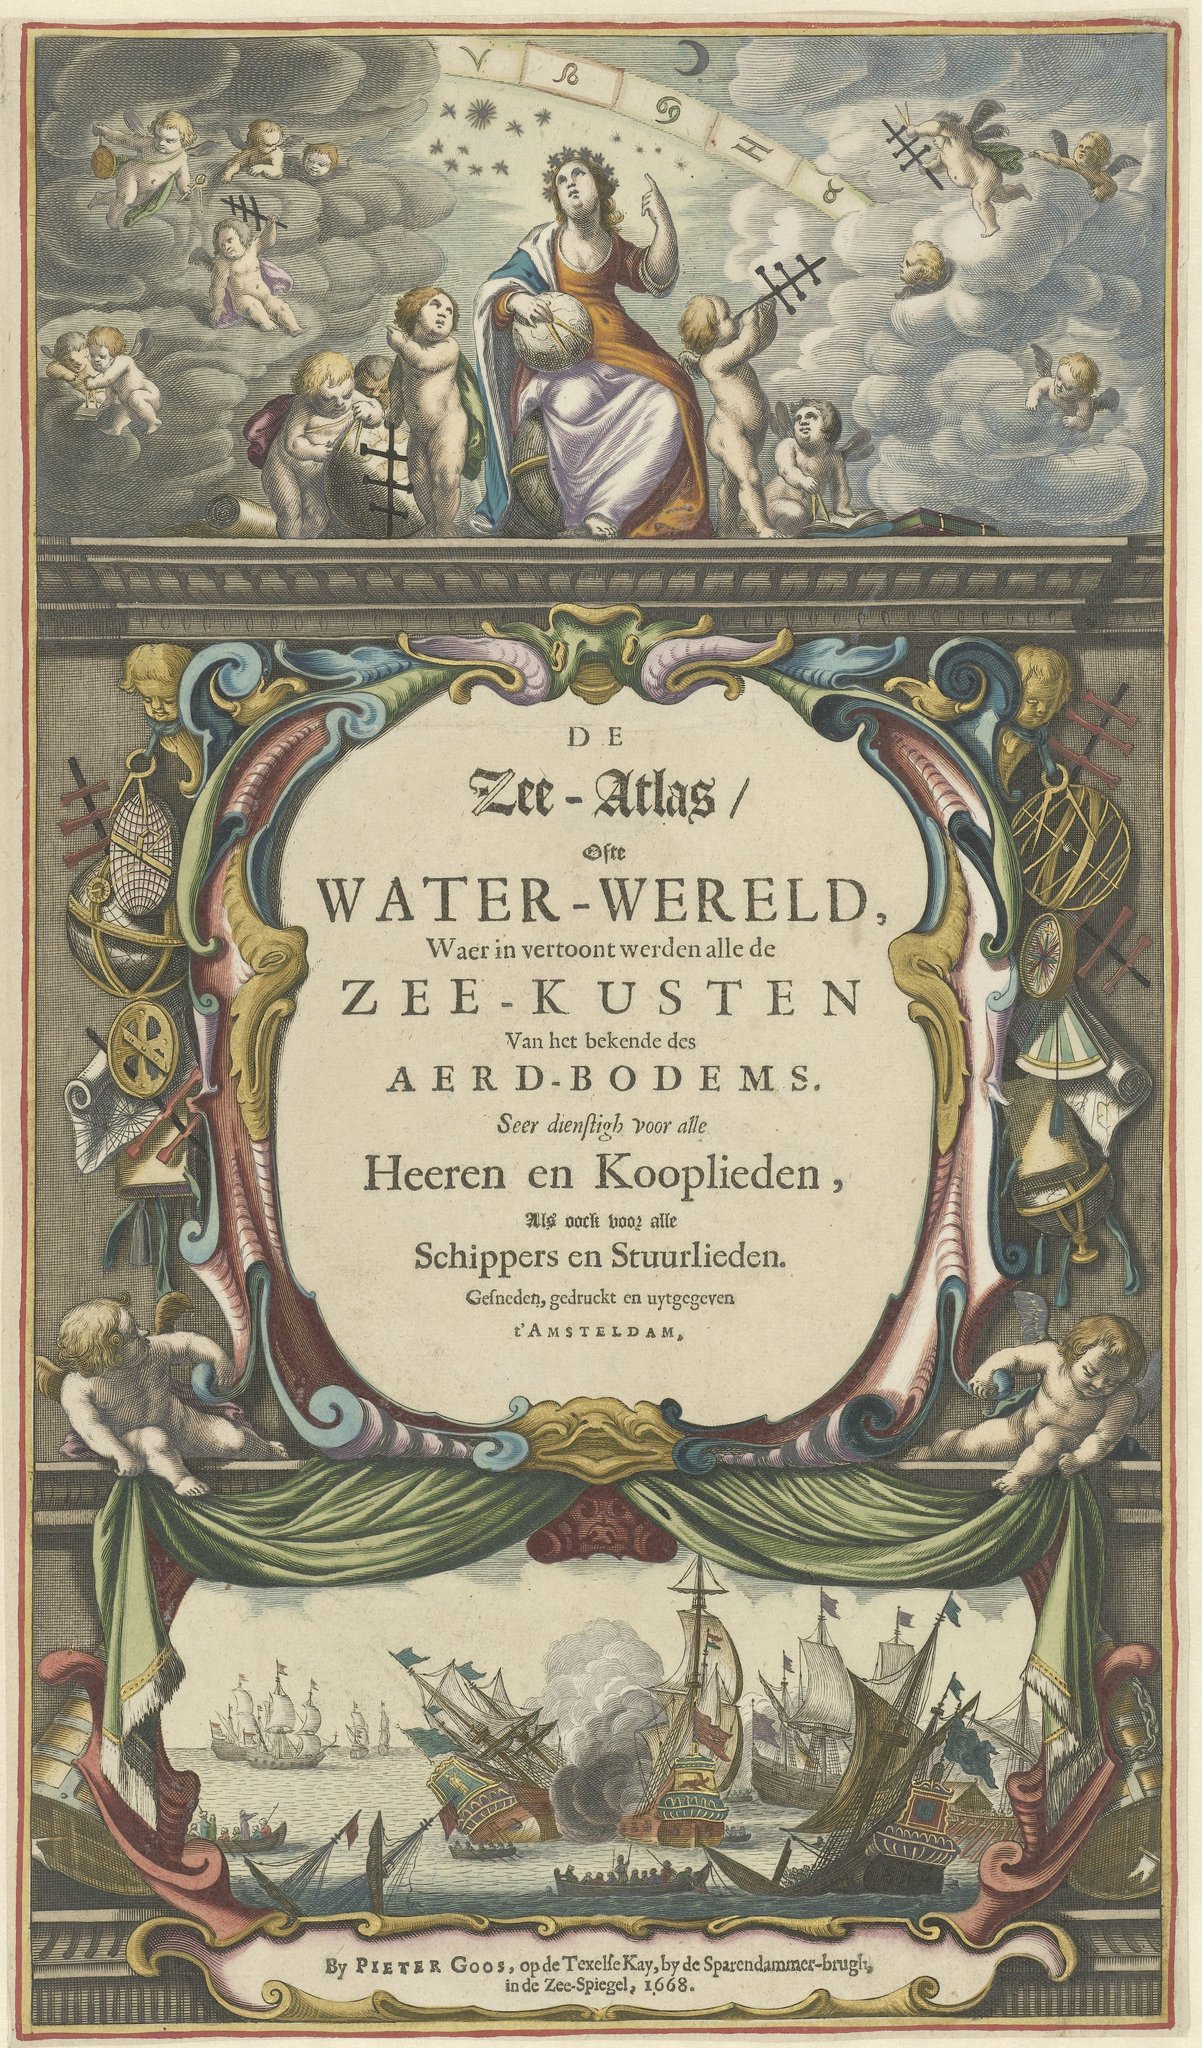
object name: print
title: Titelpagina voor Pieter Goos, De Zee-Atlas ofte Water-Wereld, 1668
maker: pieter goos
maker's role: print maker, publisher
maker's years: 1616-1675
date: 1668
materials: paper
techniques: engraving, hand coloring, letterpress printing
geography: amsterdam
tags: 'geometria' (~ quadrivium); 'geometria' (ripa), ornament ~ cartouche, zodiac; the twelve zodiacal signs together, cupids: 'amores', 'amoretti', 'putti', position-finding at sea; nautical instruments, battle, fighting in general (+ oared ships, e.g.: galley)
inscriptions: collector's mark: Lugt 2228, collector's mark: Lugt 2760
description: Centraal in een cartouche de titel van het boekwerk. Boven de cartouche de personificatie Geometrie, met rondom haar putti die met geometrische instrumenten zoals passers kaarten en globes afmeten. Onder de cartouche een zeeslag tussen enkele galjoenen.